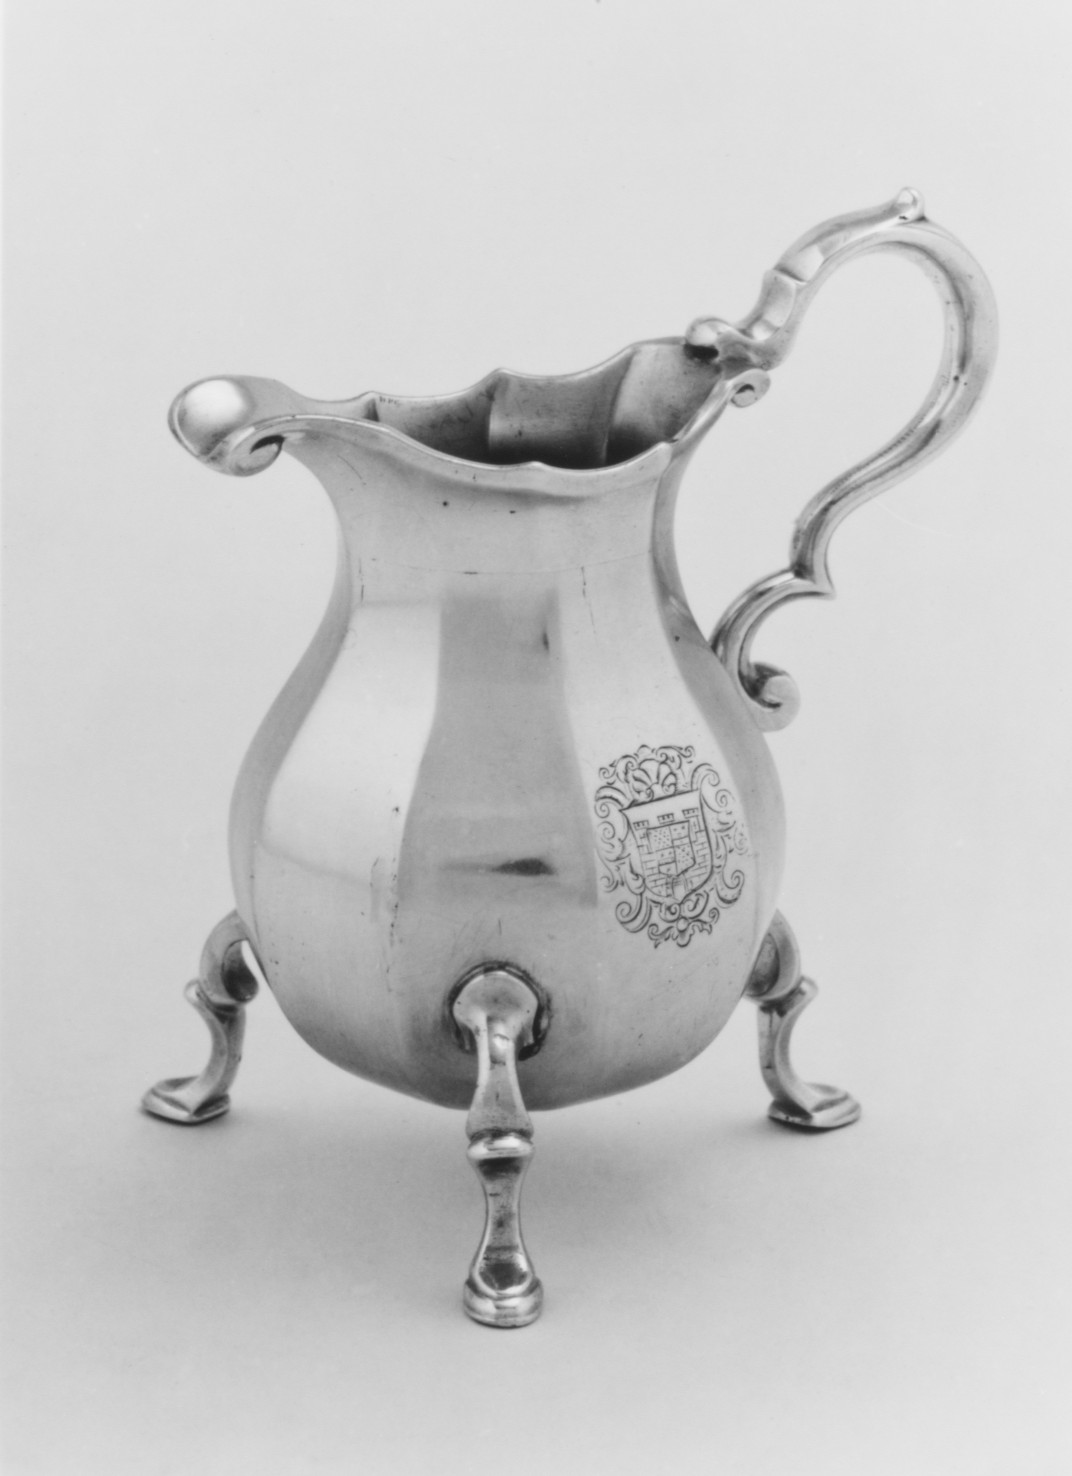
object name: jug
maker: bernard fletcher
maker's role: maker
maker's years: 1725-1741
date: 1726-1727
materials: silver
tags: coat of arms